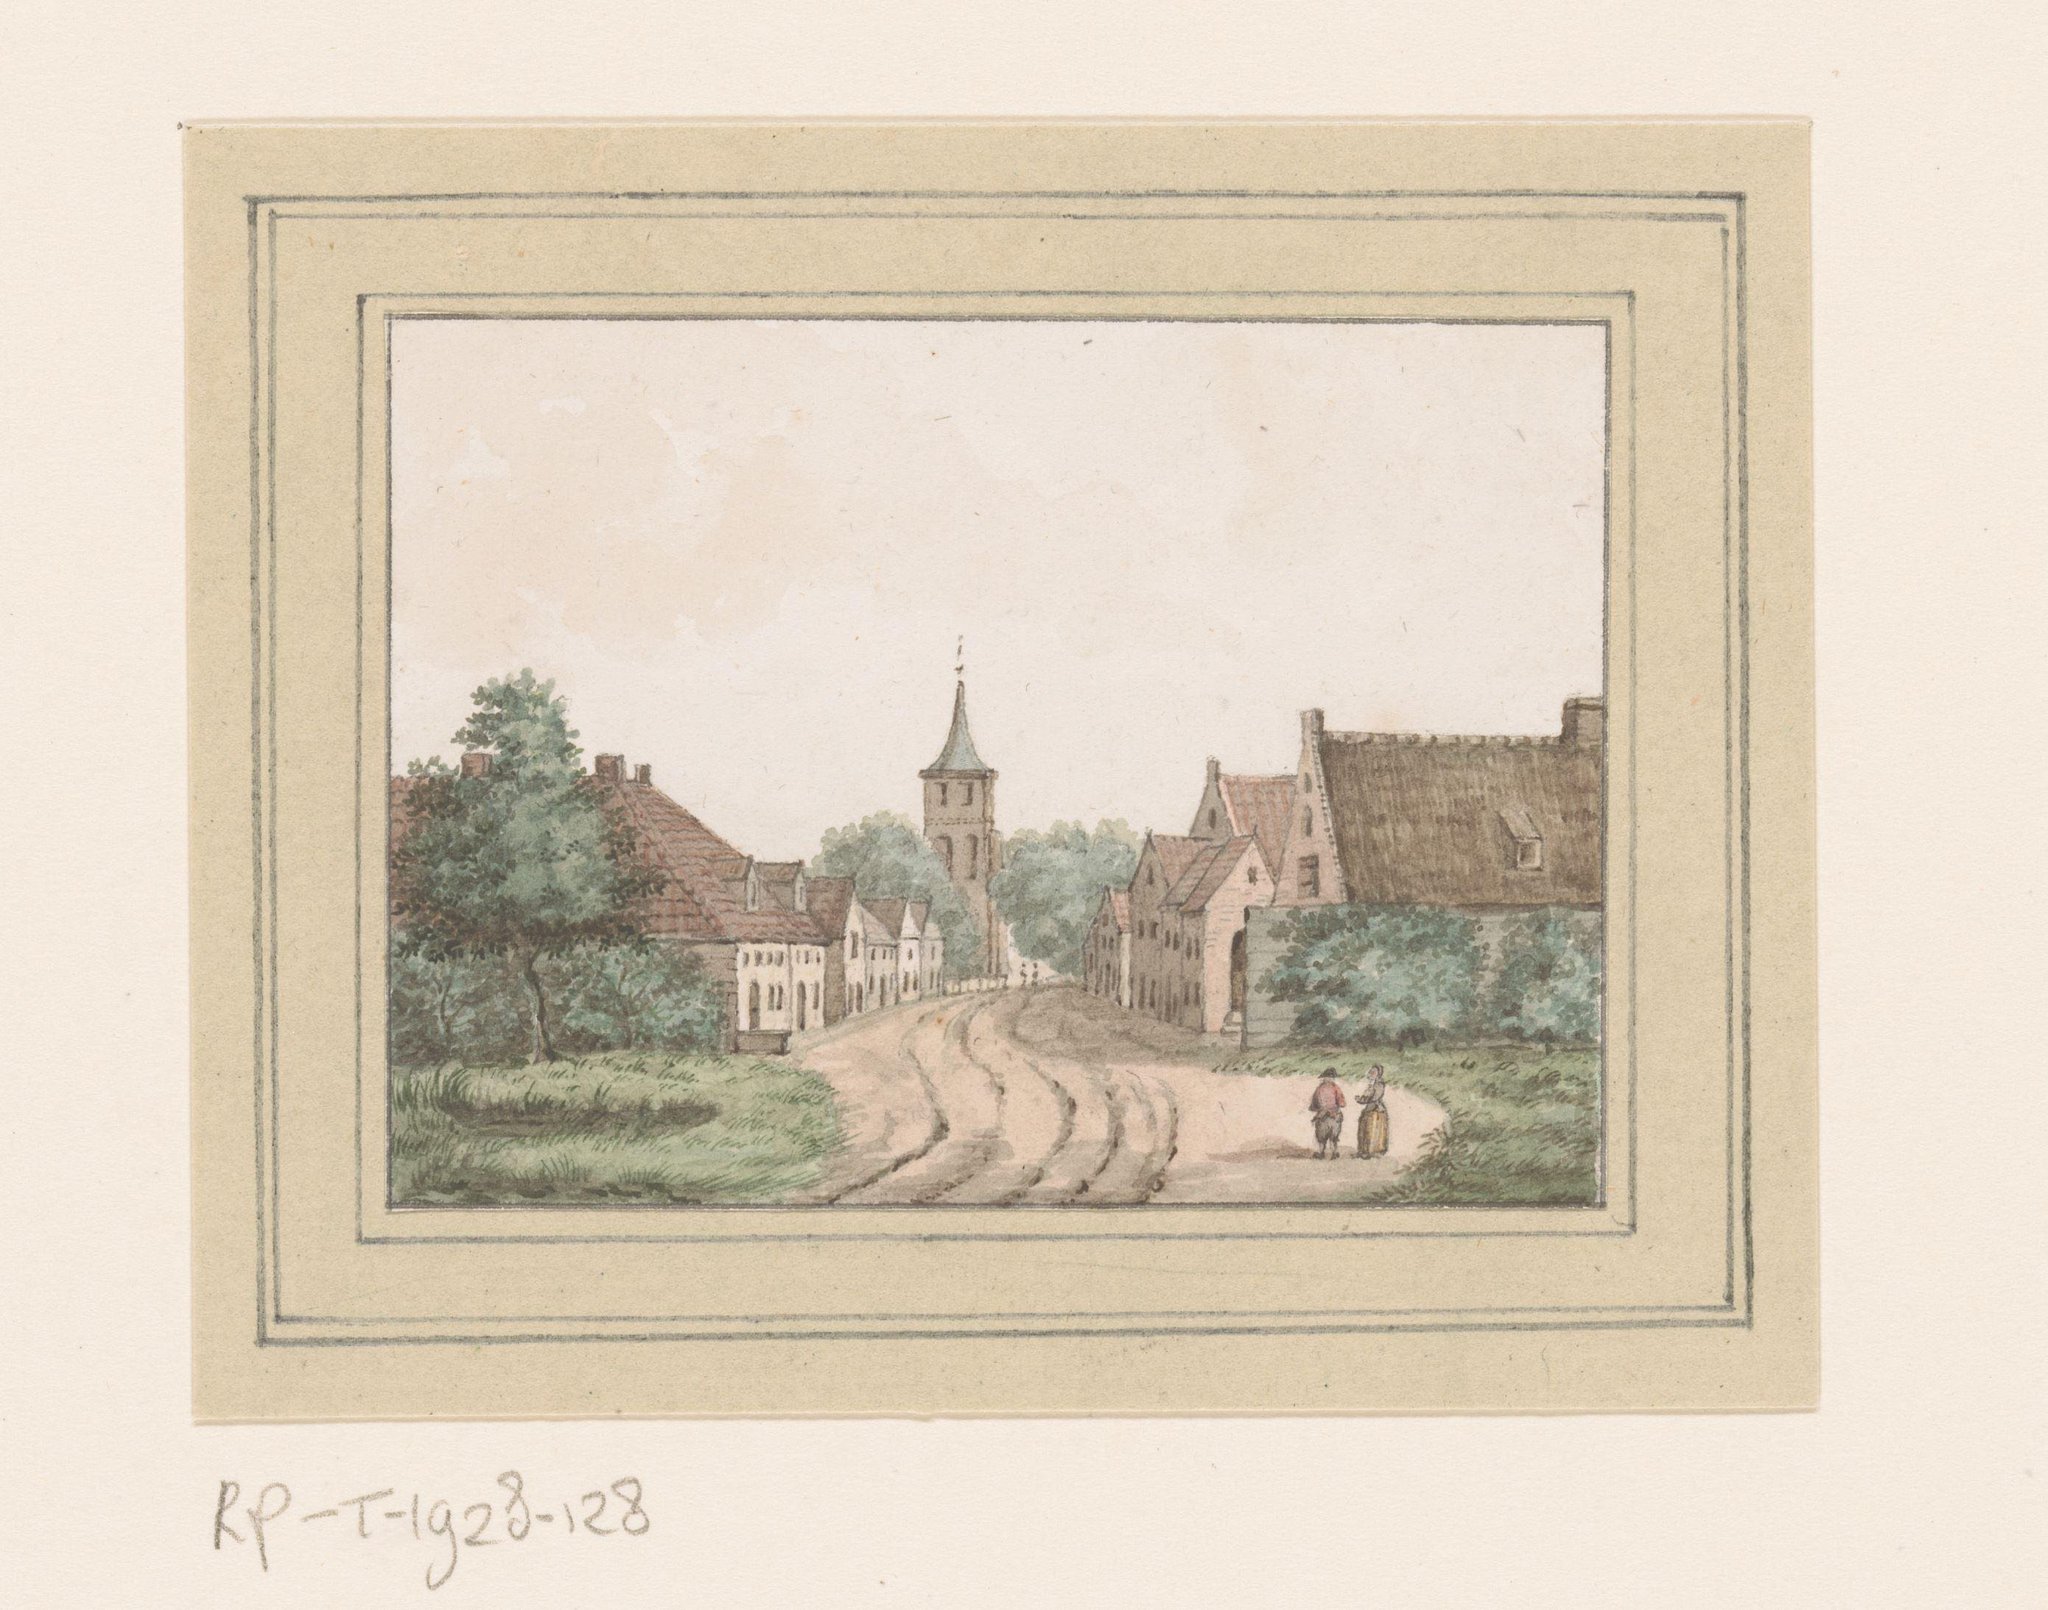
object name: drawing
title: Gezicht op Meliskerke te Zeeland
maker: Anonymous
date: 1754-1800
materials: ink, paper, pencil, watercolor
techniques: brush, pen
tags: prospect of village, silhouette of village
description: Kopie naar de prent van Hendrik Spilman, zie RP-P-AO-15-126-6-1.